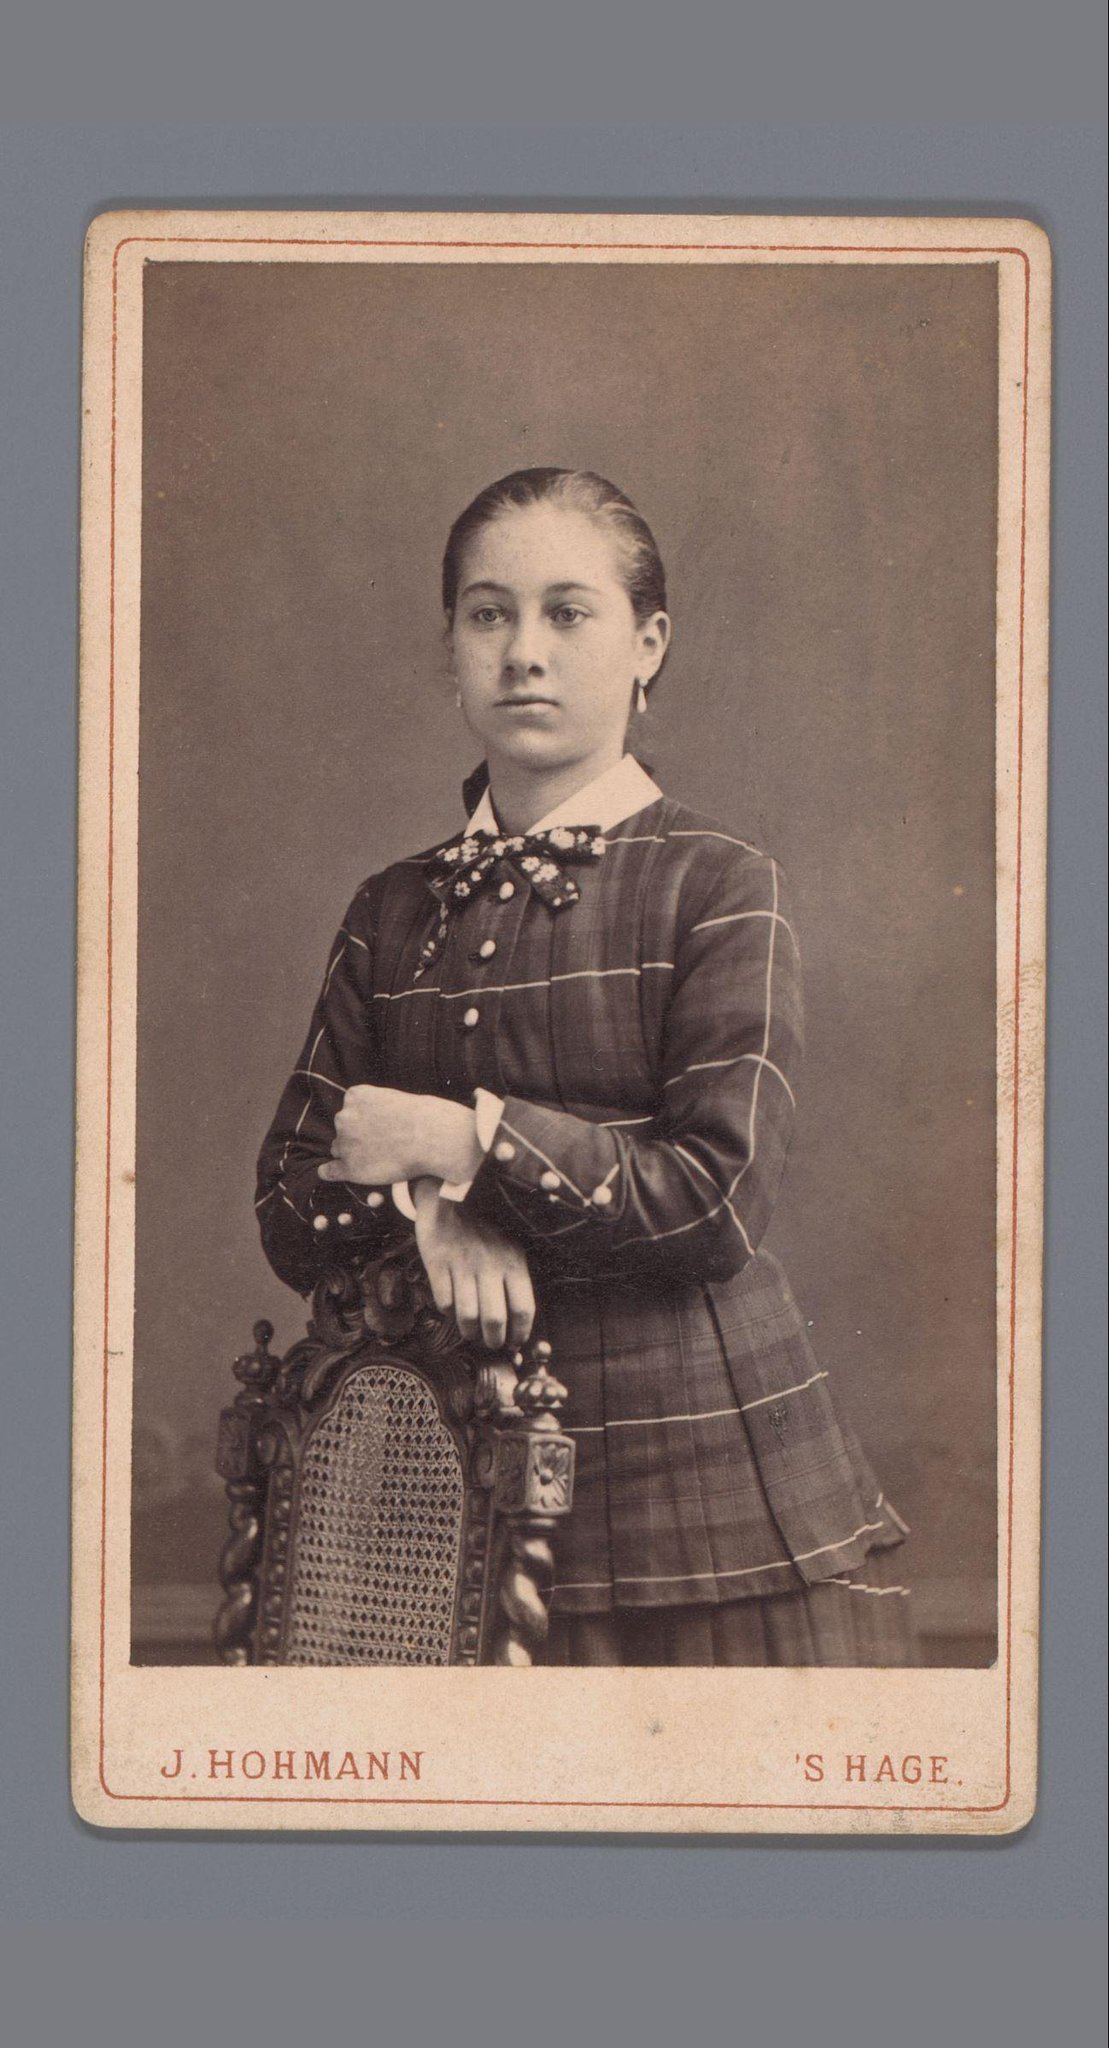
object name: carte de visite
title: Portret van een onbekende vrouw, staande achter een stoel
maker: jacob hohmann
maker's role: fotograaf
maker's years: 1833-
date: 1859-1893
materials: cardboard, paper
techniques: albumen print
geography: the hague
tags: historical persons - bb - woman, chair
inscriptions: inscription: ‘H/ Photographisch Atelier/ van J. HOHMANN/ Willemstraat 59,/ 'S GRAVENHAGE./ Voor nabestellingen worden alle/ negativen bewaard.’